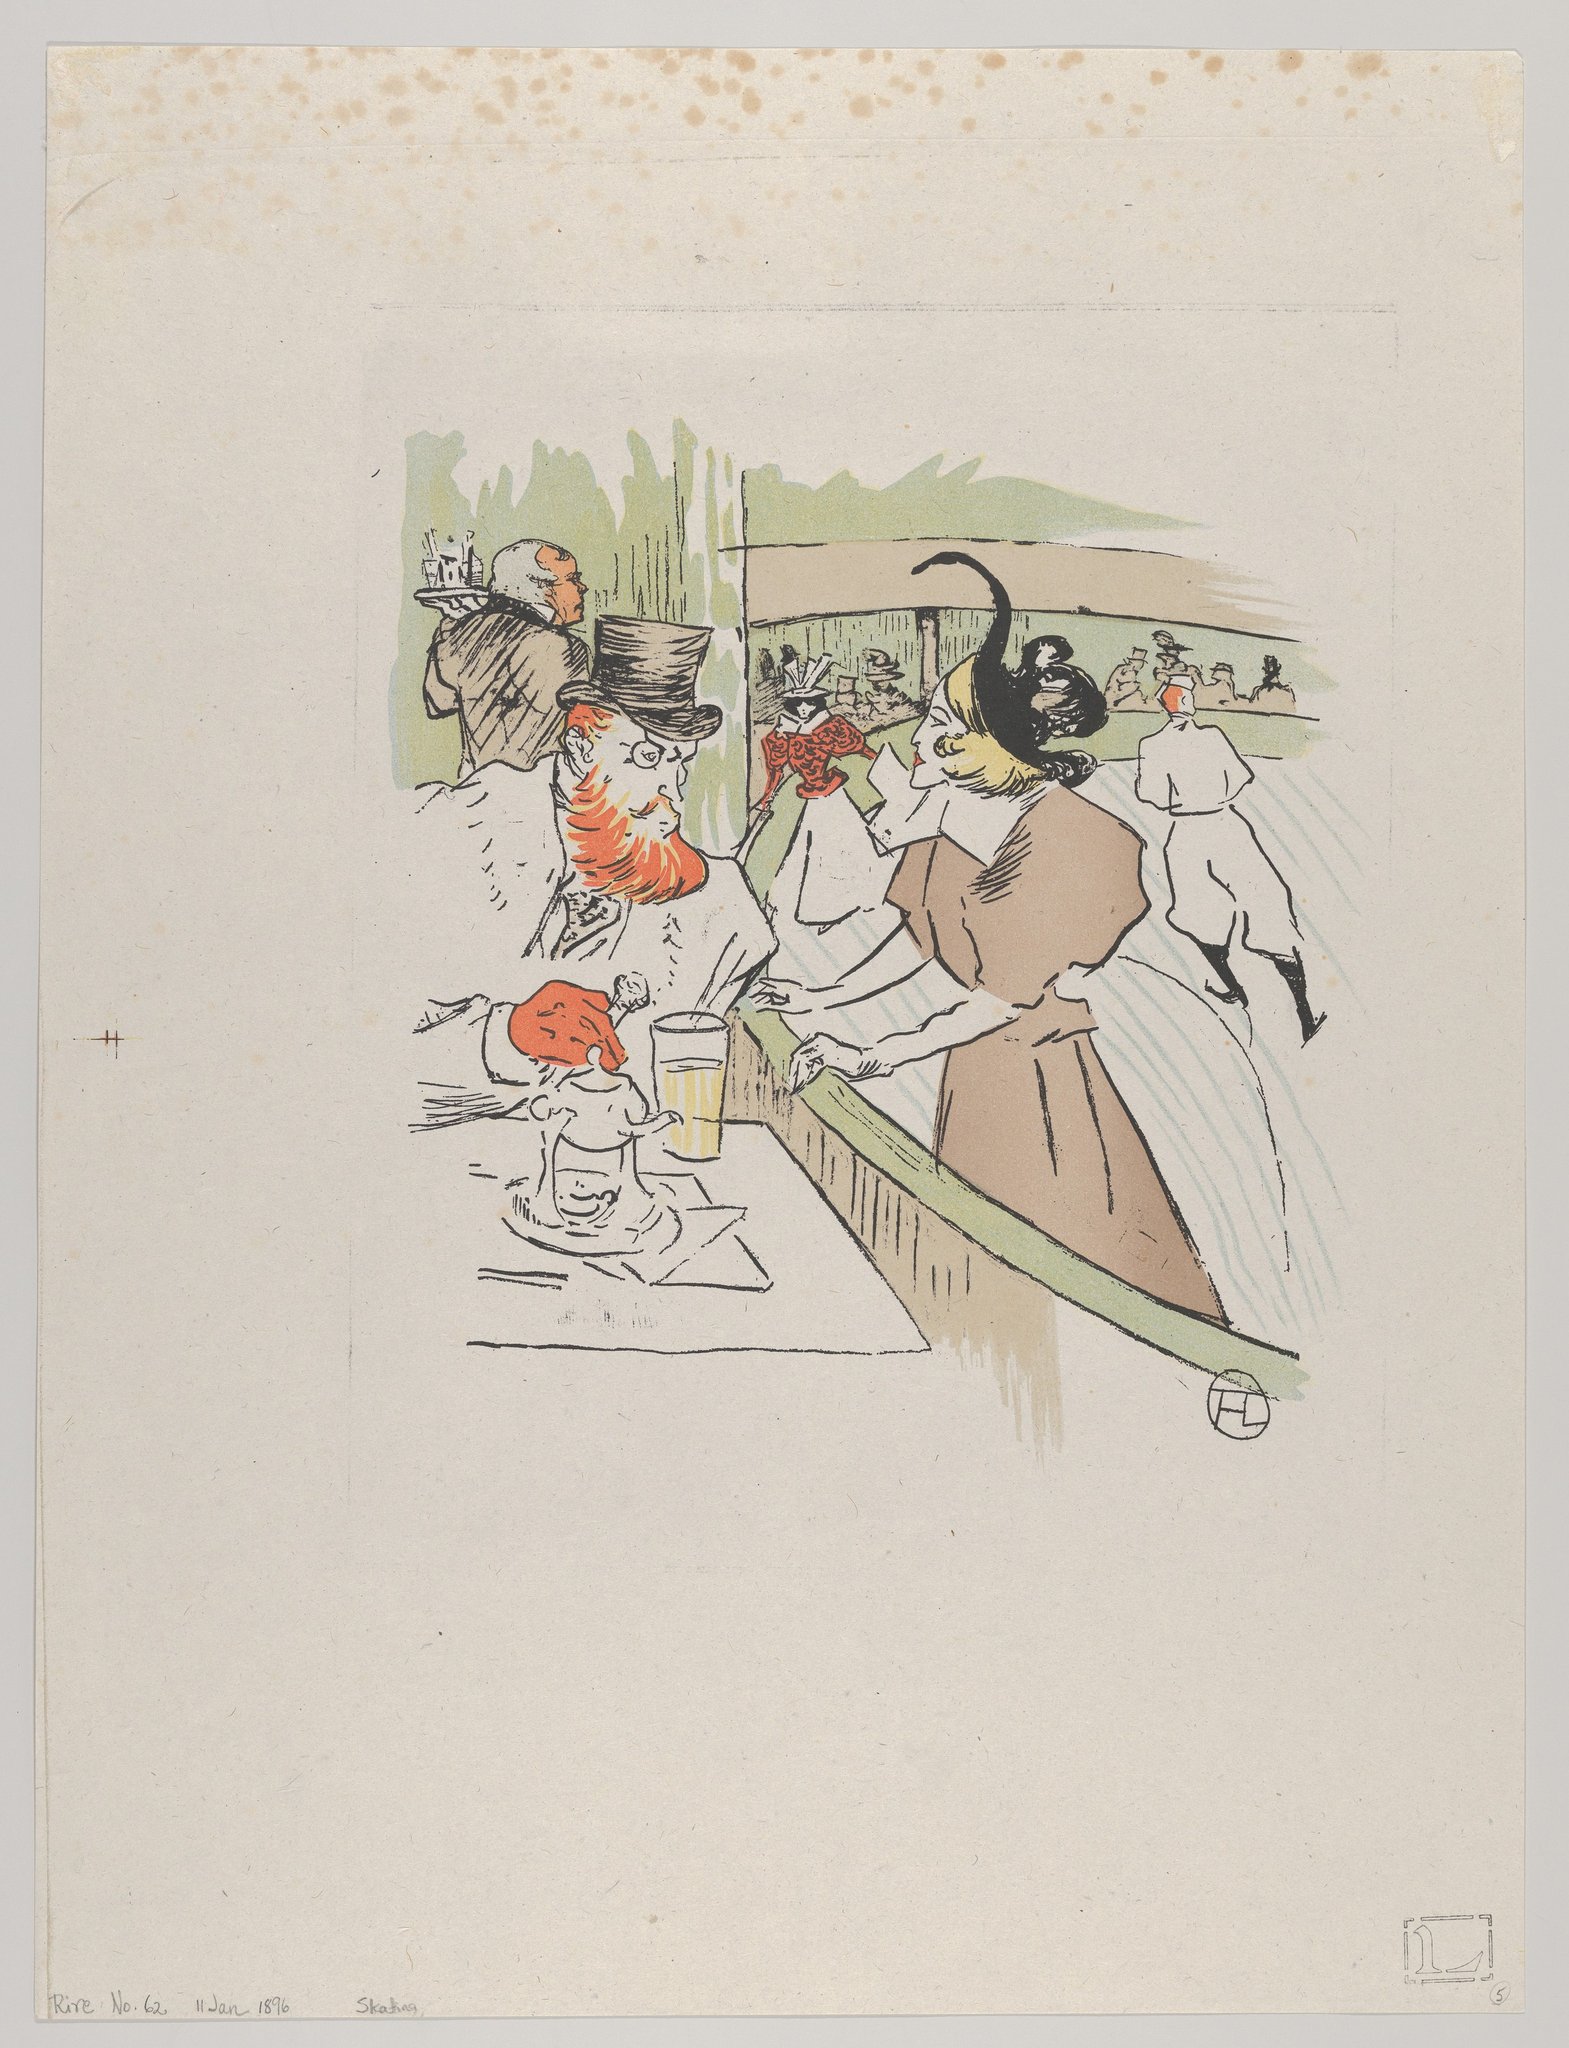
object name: print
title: Skating, from Le Rire, No. 62, 11 January 1896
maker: henri de toulouse-lautrec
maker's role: artist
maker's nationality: french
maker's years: 1864-1901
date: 1896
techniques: lithograph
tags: men,women